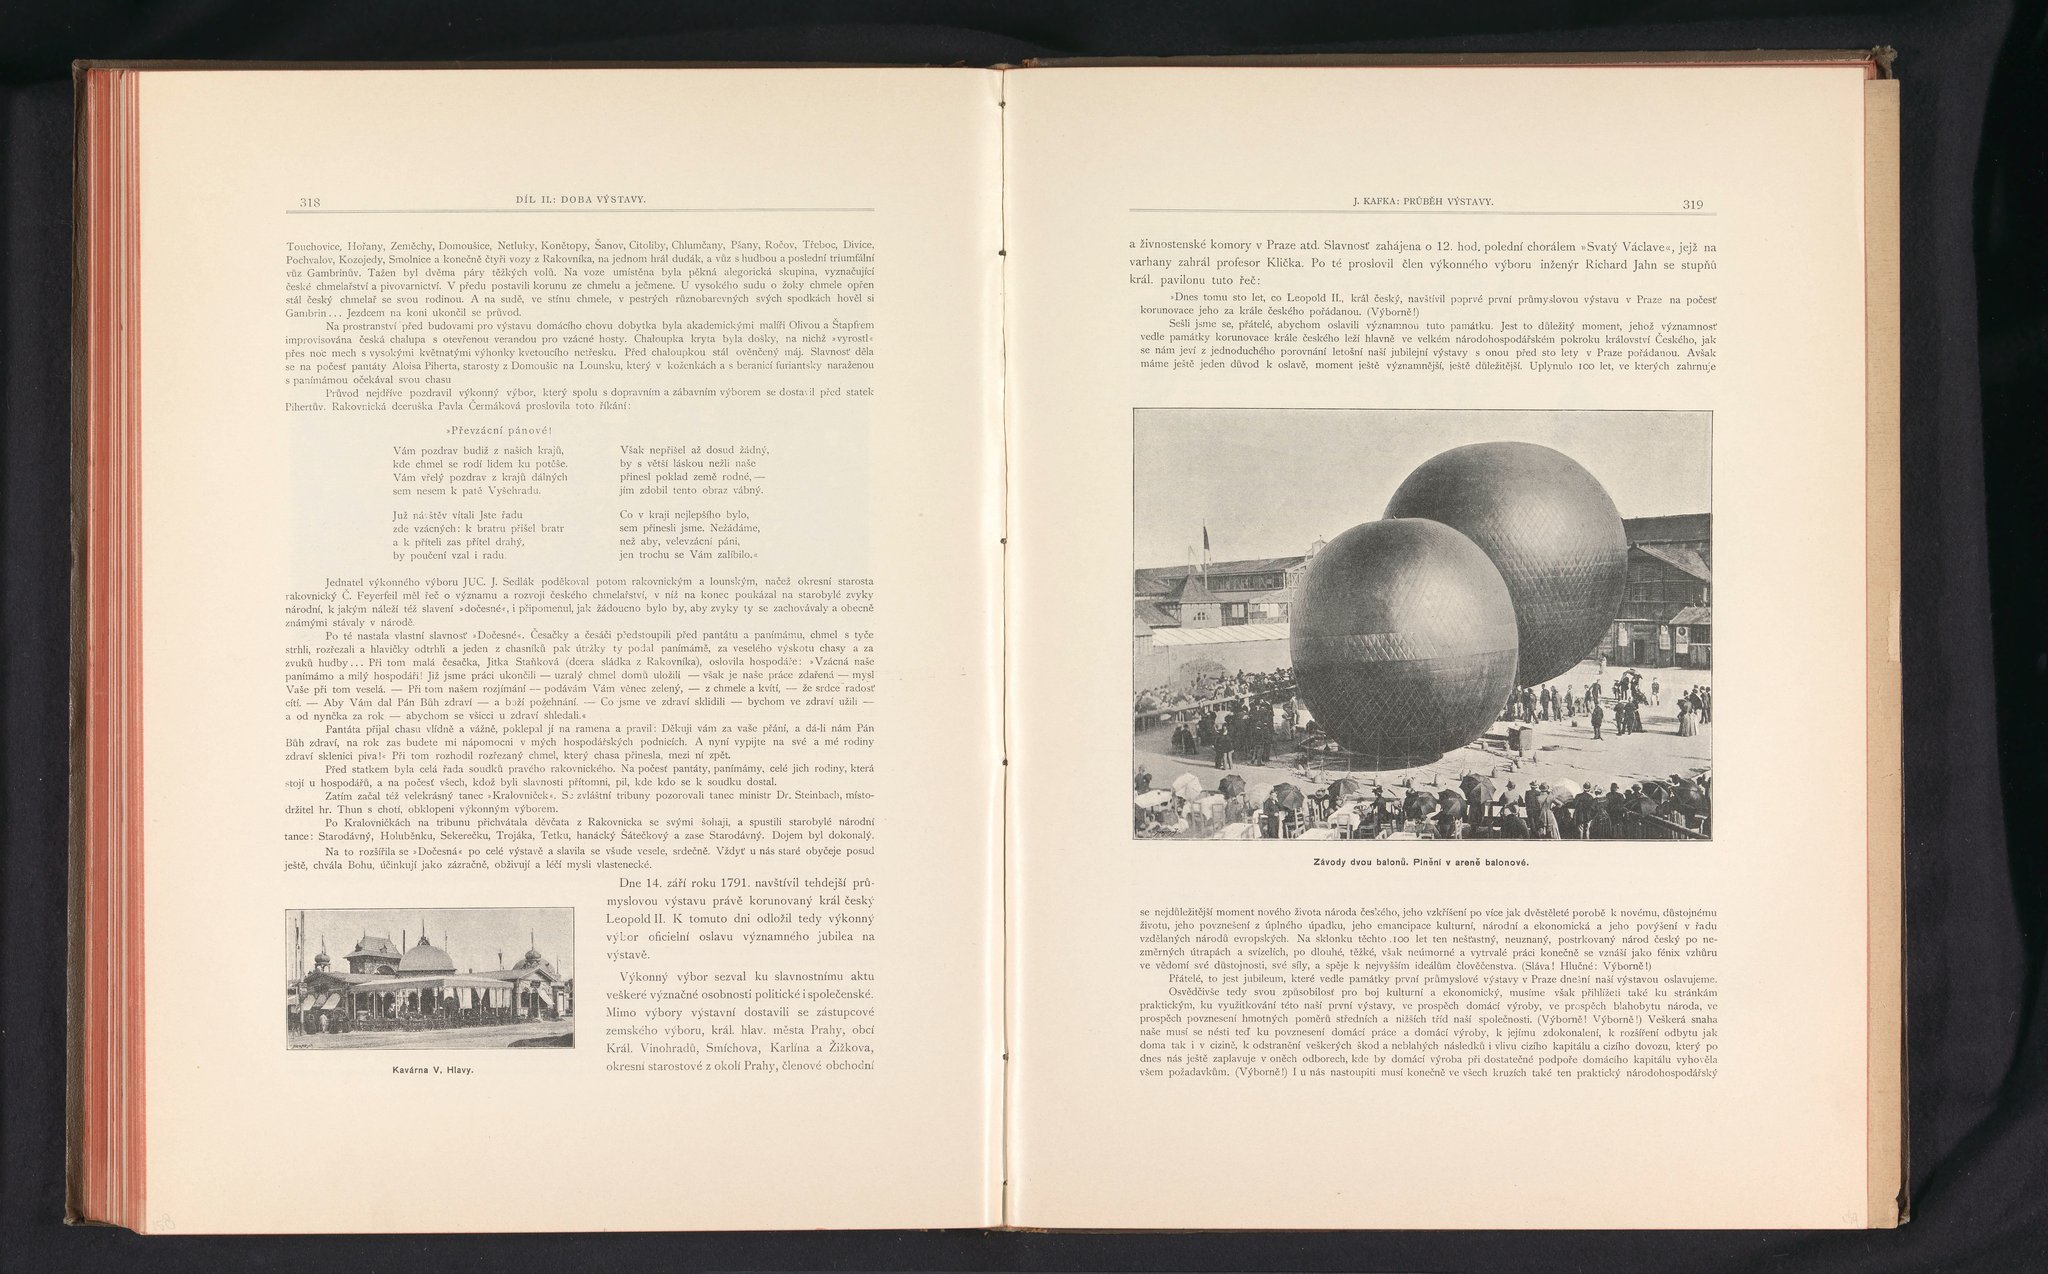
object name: page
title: Exterieur van een café te Praag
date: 1891-1893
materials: paper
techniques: autotype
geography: prague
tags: façade (of house or building), hotel, hostelry, inn